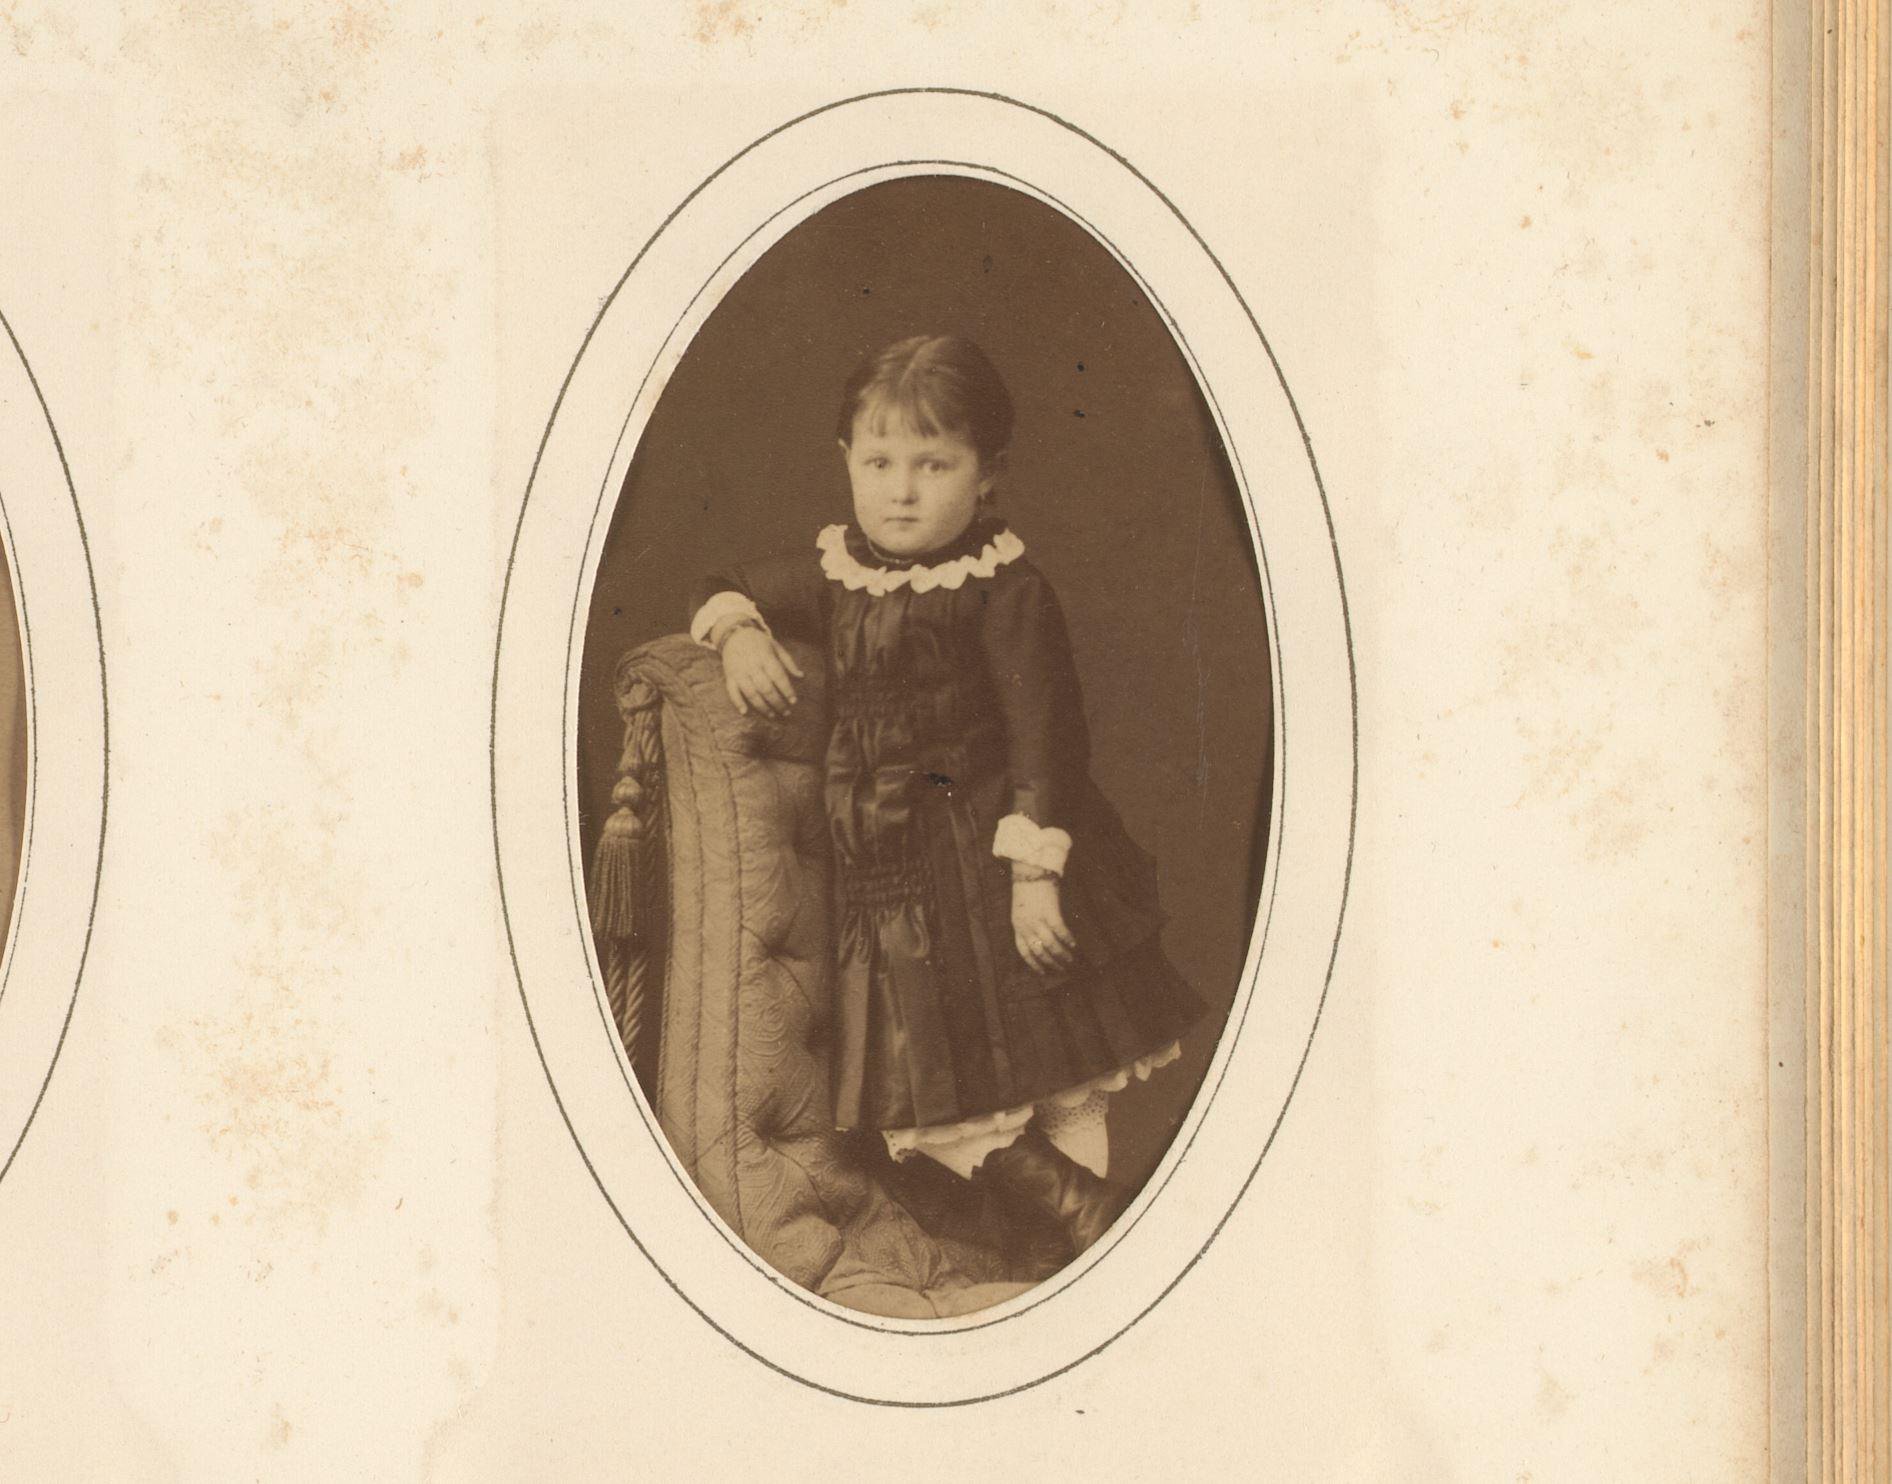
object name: album leaf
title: Portret van een meisje, staand op een stoel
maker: johannes hendrikus kramer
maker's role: fotograaf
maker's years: 1846-1901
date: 1863-1901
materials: cardboard, photographic support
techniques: albumen print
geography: utrecht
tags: historical persons - bb - woman, toddler (female), standing figure - aa - female human figure, chair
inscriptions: inscription: ‘J. H. Kramer/ Mariaplaats naast de Societeit de Vereeniging/ Utrecht./ De platen blijven ter nabestelling bewaard.’